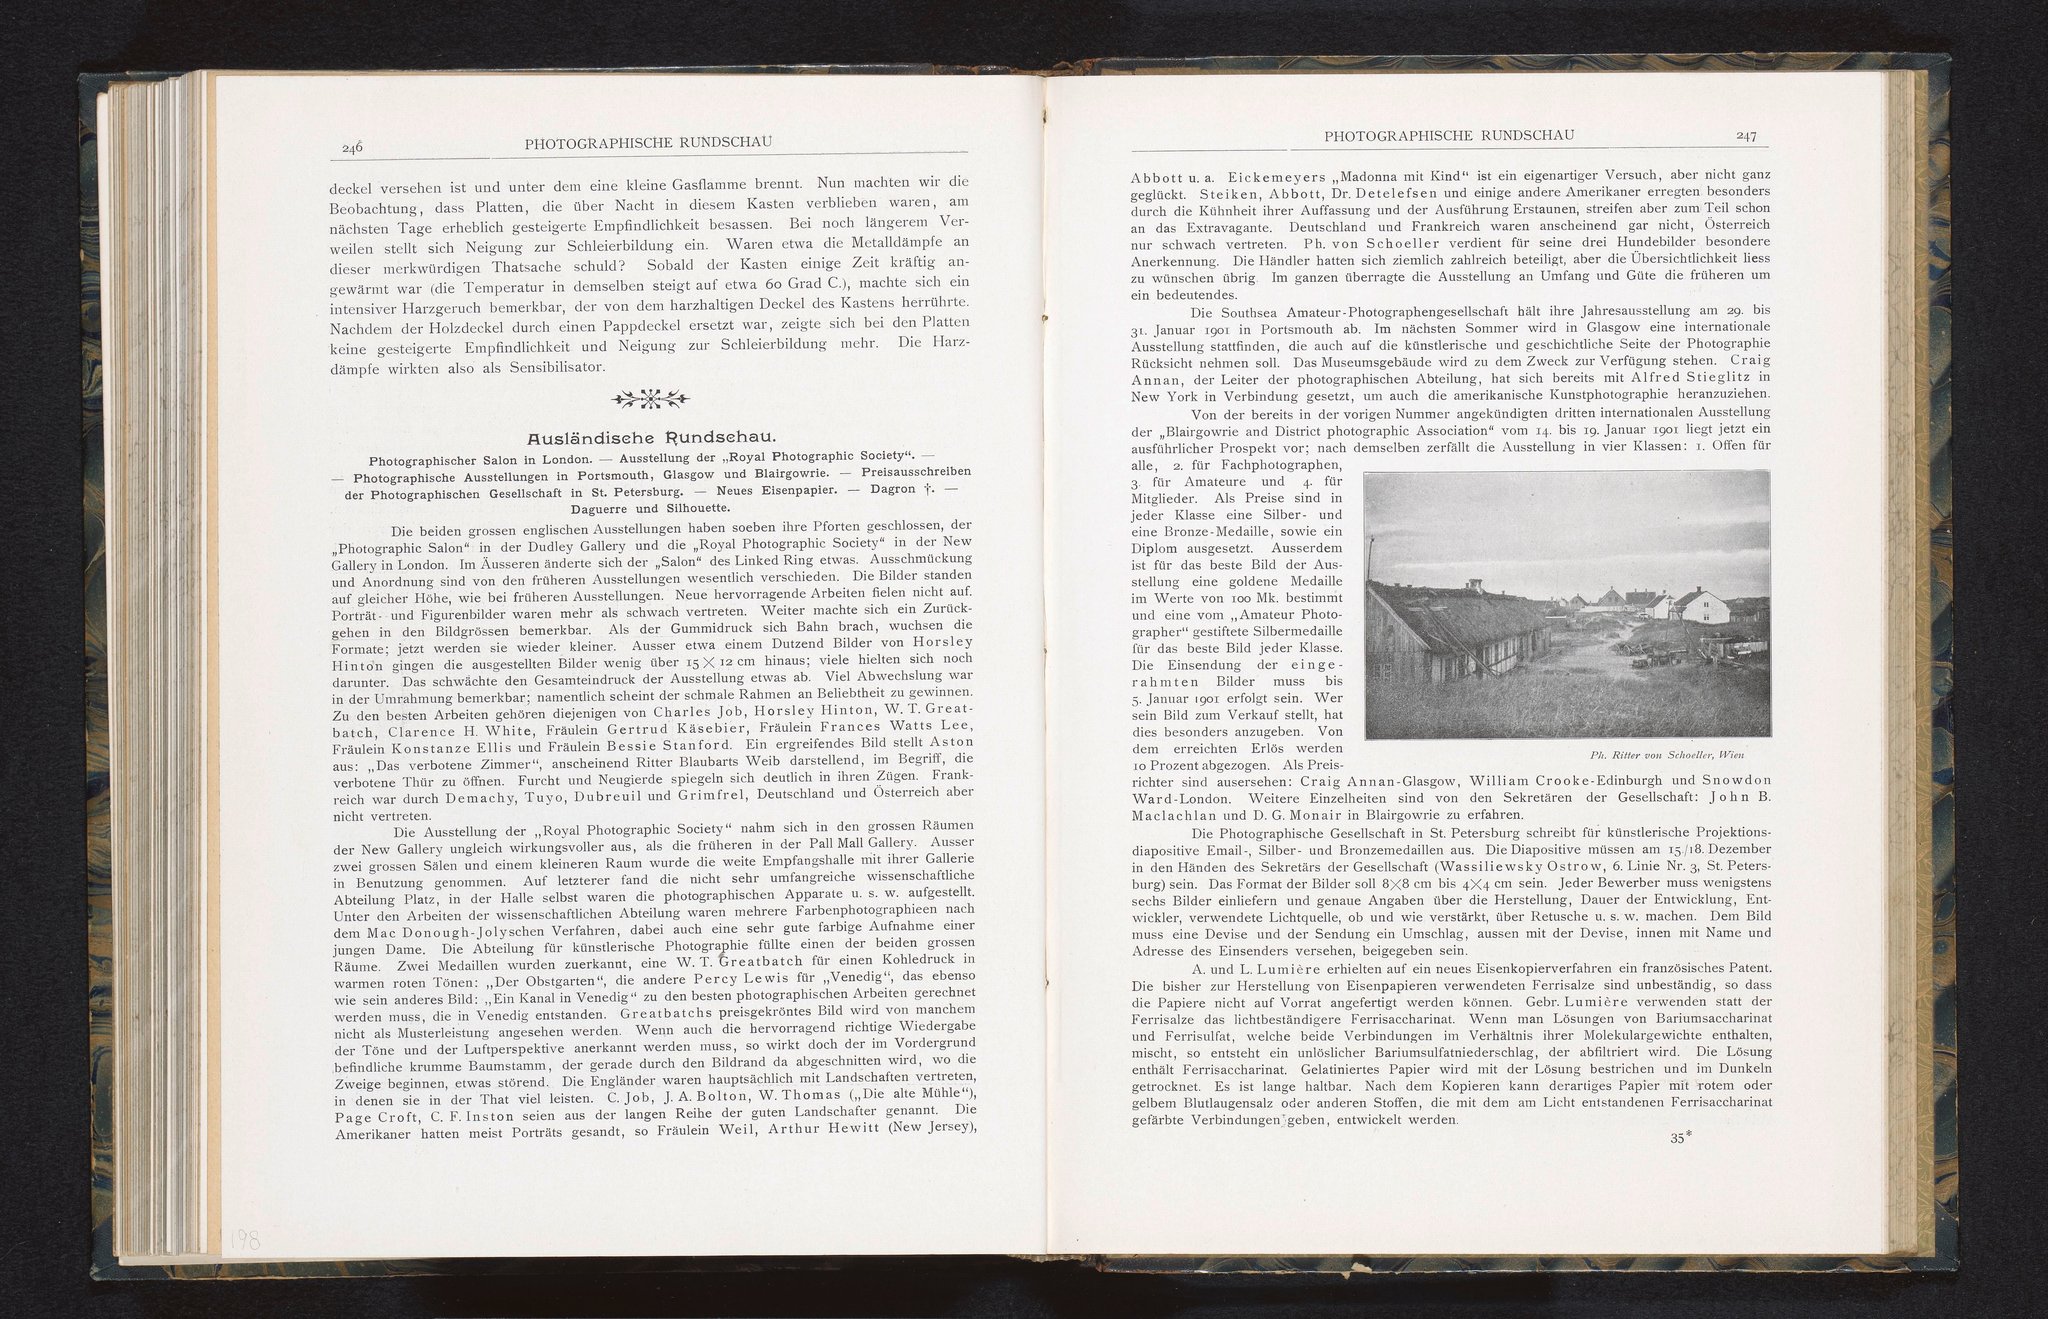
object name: page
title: Gezicht op een dorp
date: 1895-1900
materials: paper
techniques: autotype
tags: city-view in general; 'veduta', rural housing, e.g. country-house, villa, cottage